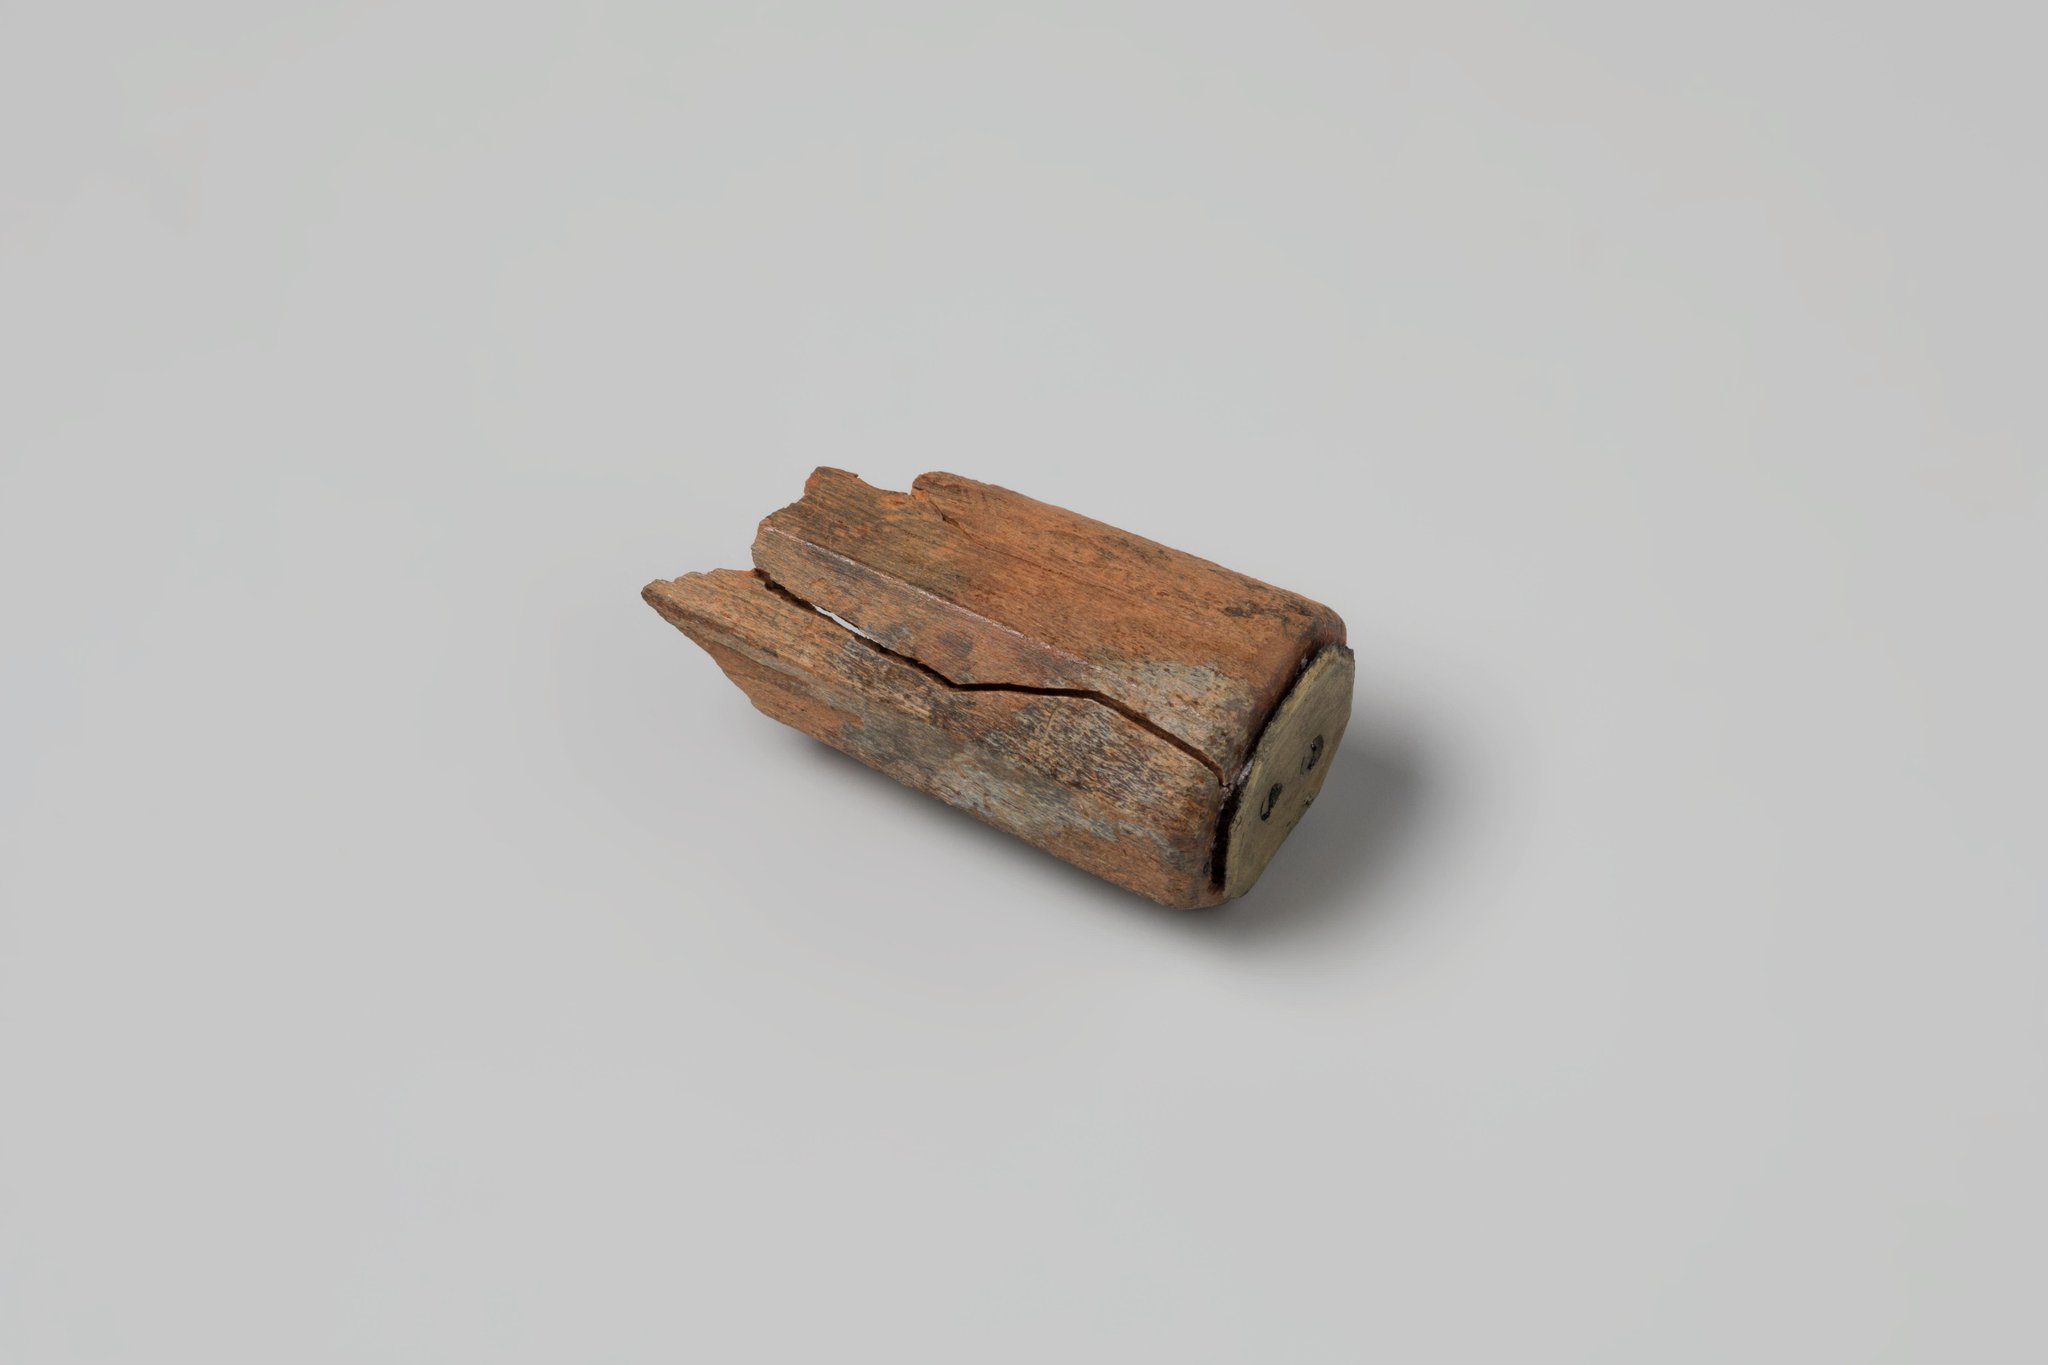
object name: knife handle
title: Messenheft uit het wrak van de Oost-Indiëvaarder Hollandia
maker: Anonymous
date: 1700-1743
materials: bone, brass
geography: netherlands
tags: verenigde oostindische compagnie, hollandia (schip), annet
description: Knife-handle, straight-sided: tapering; fragm of upper end, id. NG 1980-27H1701, octagonal plate riveted on flat end, hollow core with fragm of original stuffing.